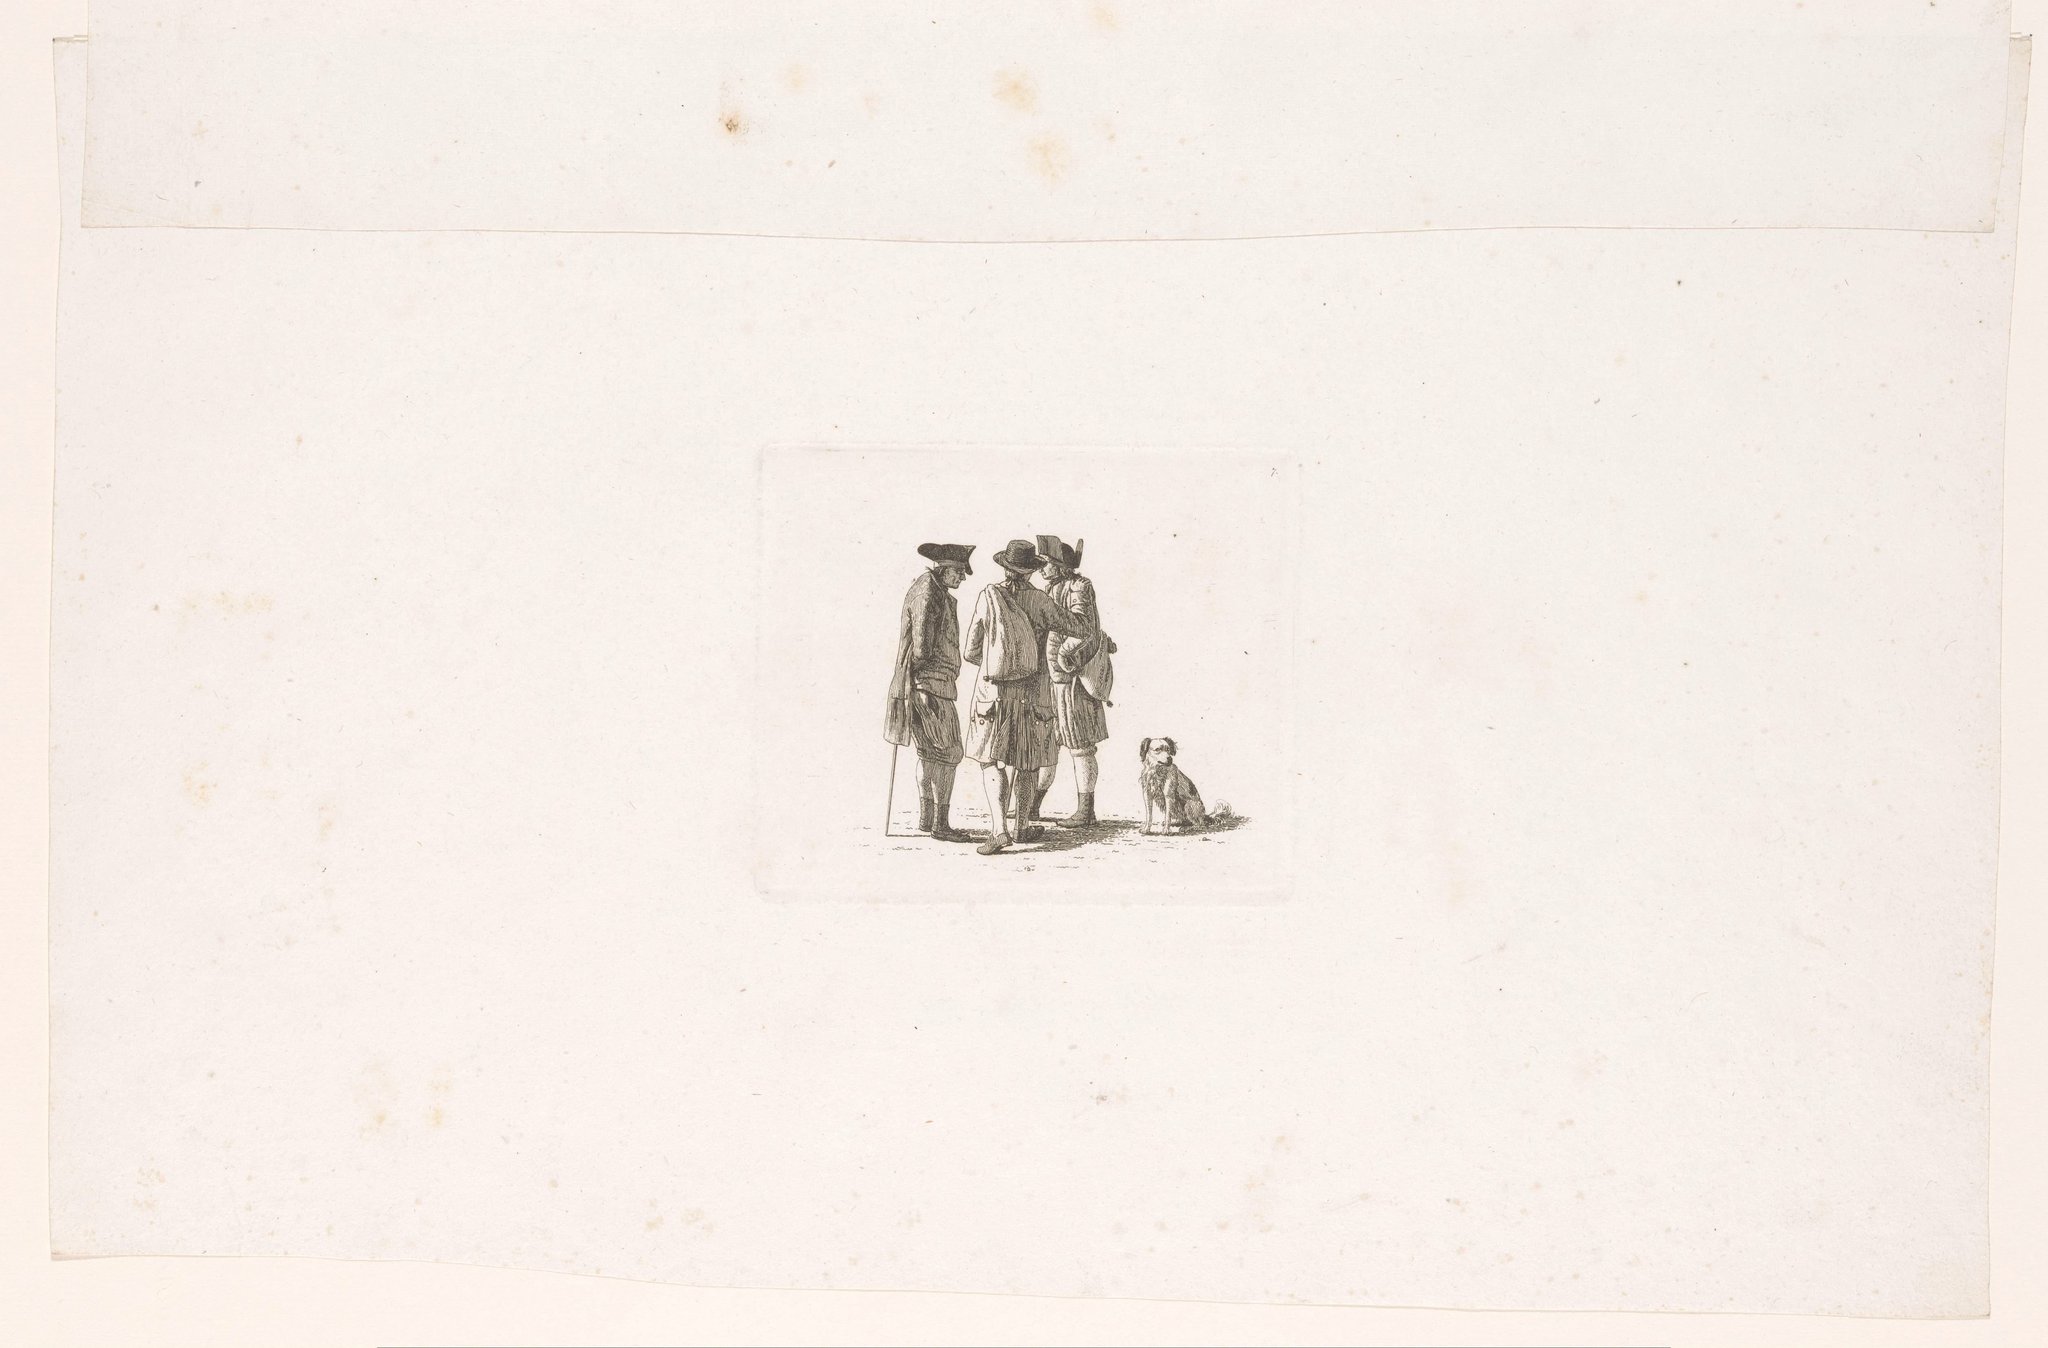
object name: print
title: Drie staande mannen en een hond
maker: johan jakob biedermann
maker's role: painter, print maker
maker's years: 1763-1830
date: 1778-1830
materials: paper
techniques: etching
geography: switzerland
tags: dog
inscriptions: collector's mark: Lugt 2228, watermark: ‘Thurneisen’